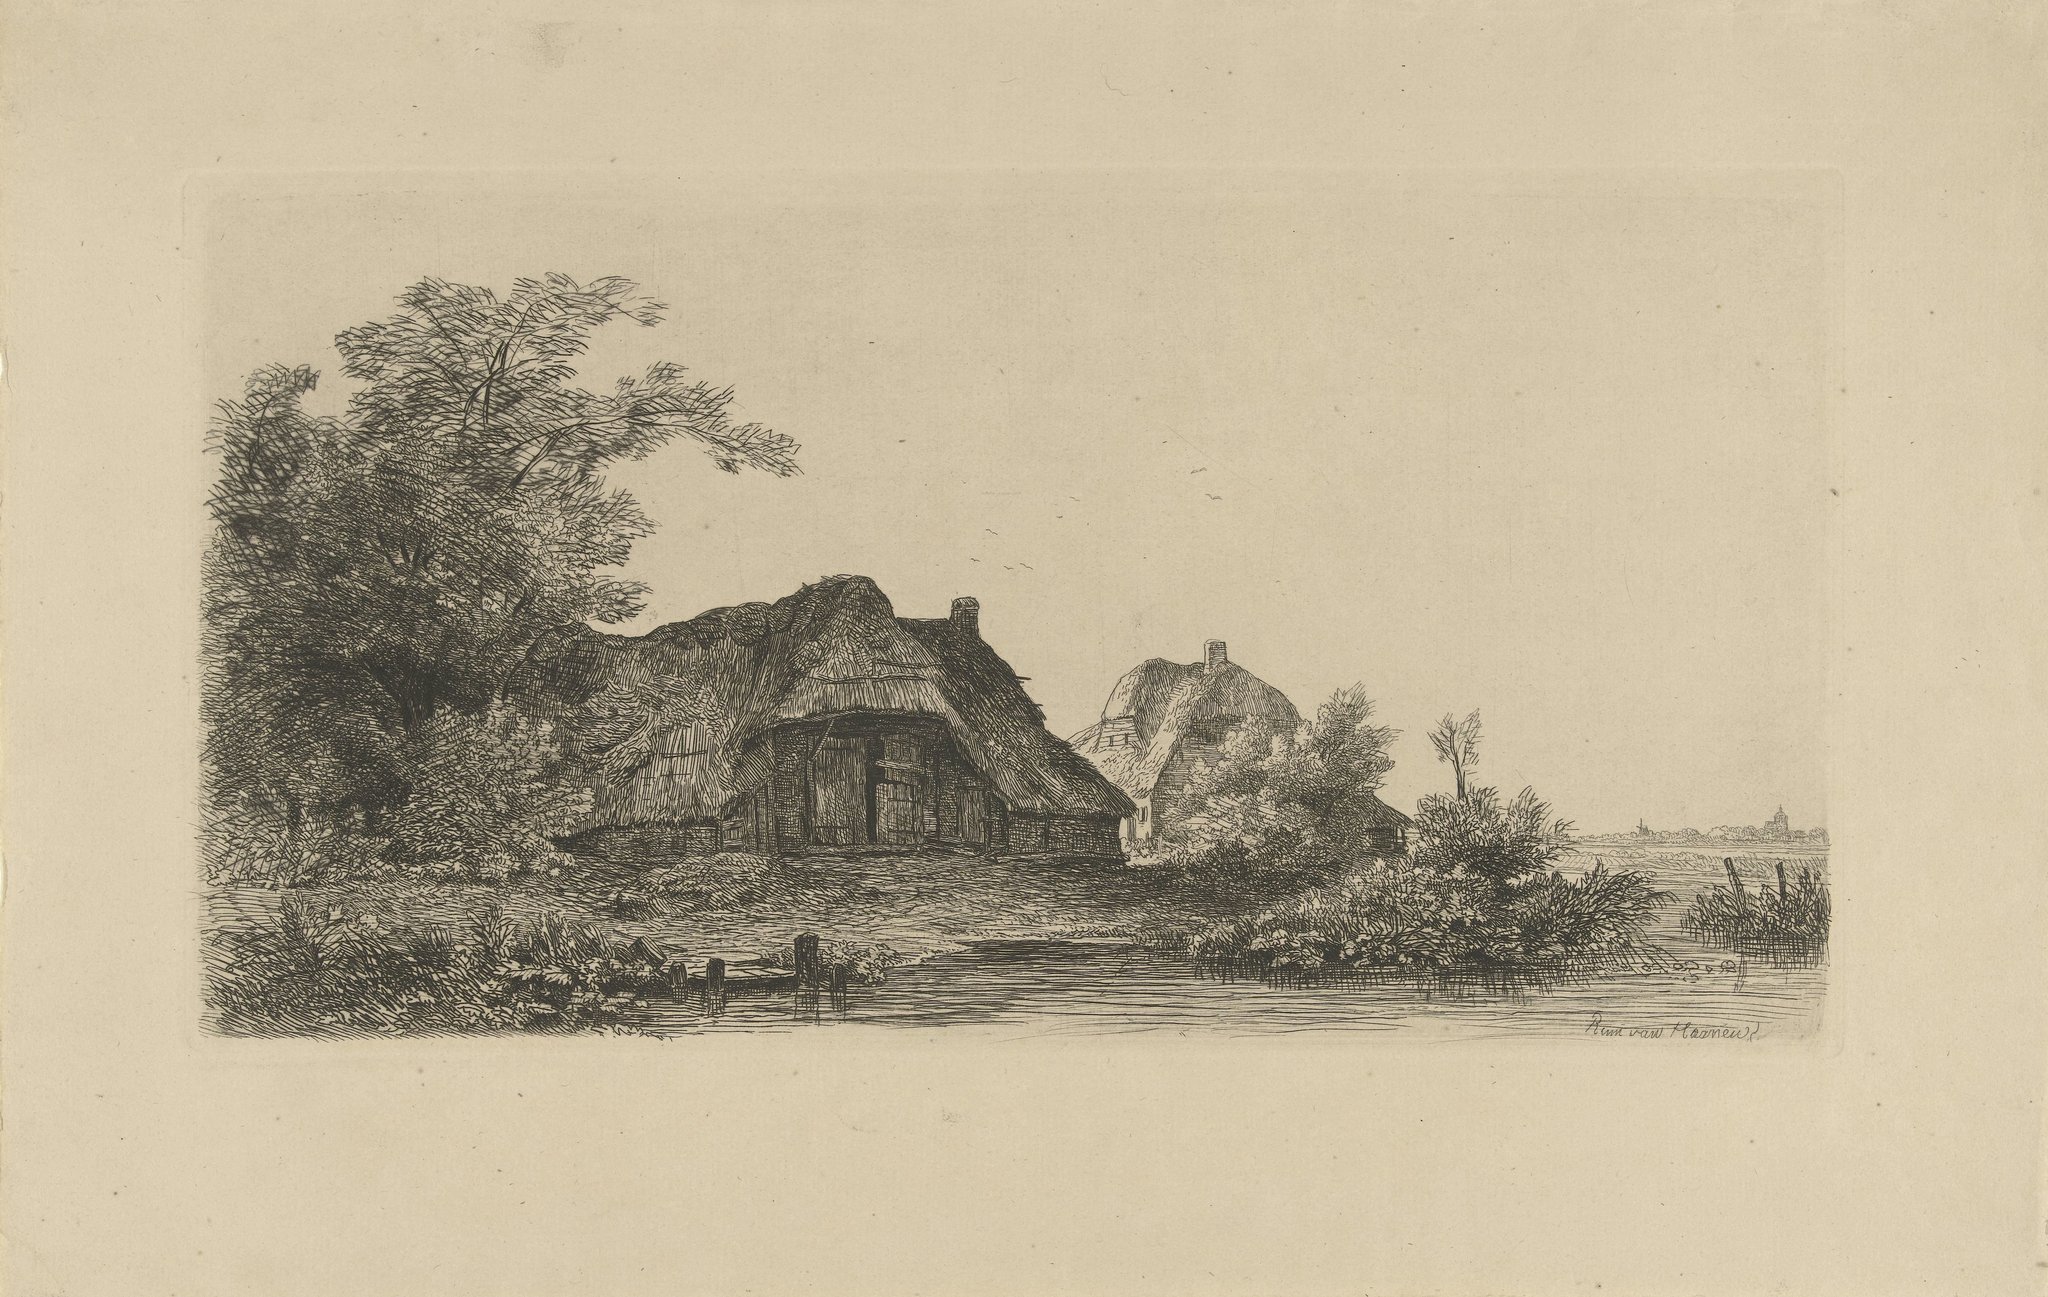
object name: print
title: Boerderijen aan het water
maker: remigius adrianus haanen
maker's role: draughtsman, painter, print maker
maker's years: 1812-1894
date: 1827-1894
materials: paper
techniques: drypoint, etching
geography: austria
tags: city-view, and landscape with man-made constructions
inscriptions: collector's mark: Lugt 2760, name: ‘Remigius Adrianus (van) Haanen’, collector's mark: Lugt 2228